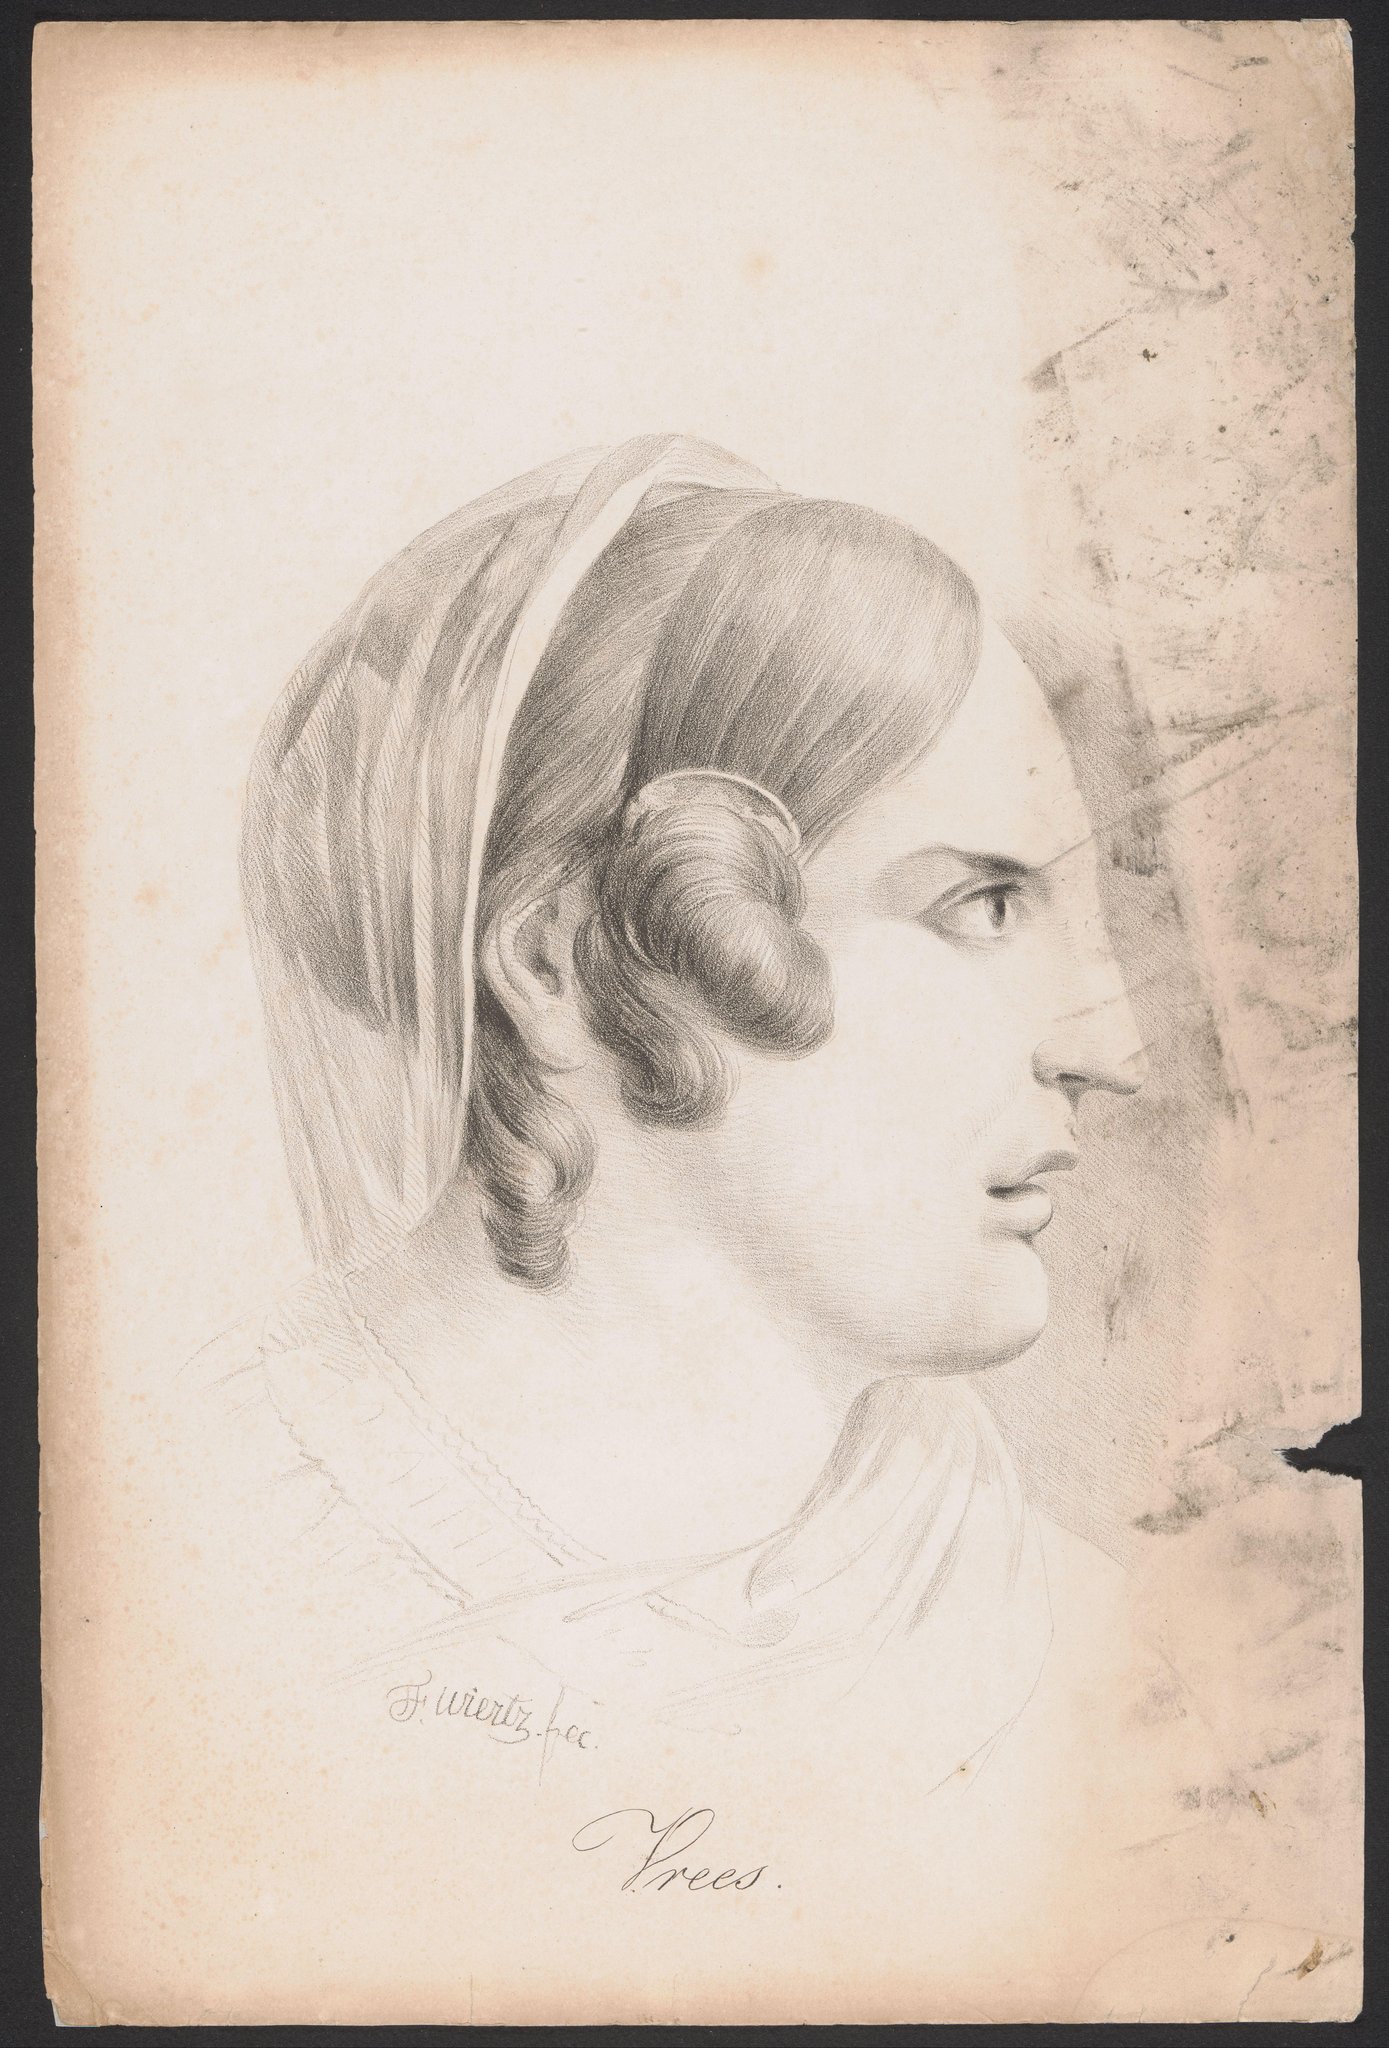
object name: print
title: Vrees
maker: henricus franciscus wiertz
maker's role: draughtsman, painter, print maker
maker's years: 1784-1858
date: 1847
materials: paper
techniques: lithograph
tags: historical persons - bb - woman (+ head (and shoulders) (portrait)), passions, emotions, affections, fear, dread; 'paura', 'timidità o timore', 'timore' (ripa)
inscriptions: collector's mark: Lugt 2228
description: Maakt deel uit van een omslag met een tekstblad en twaalf prenten.